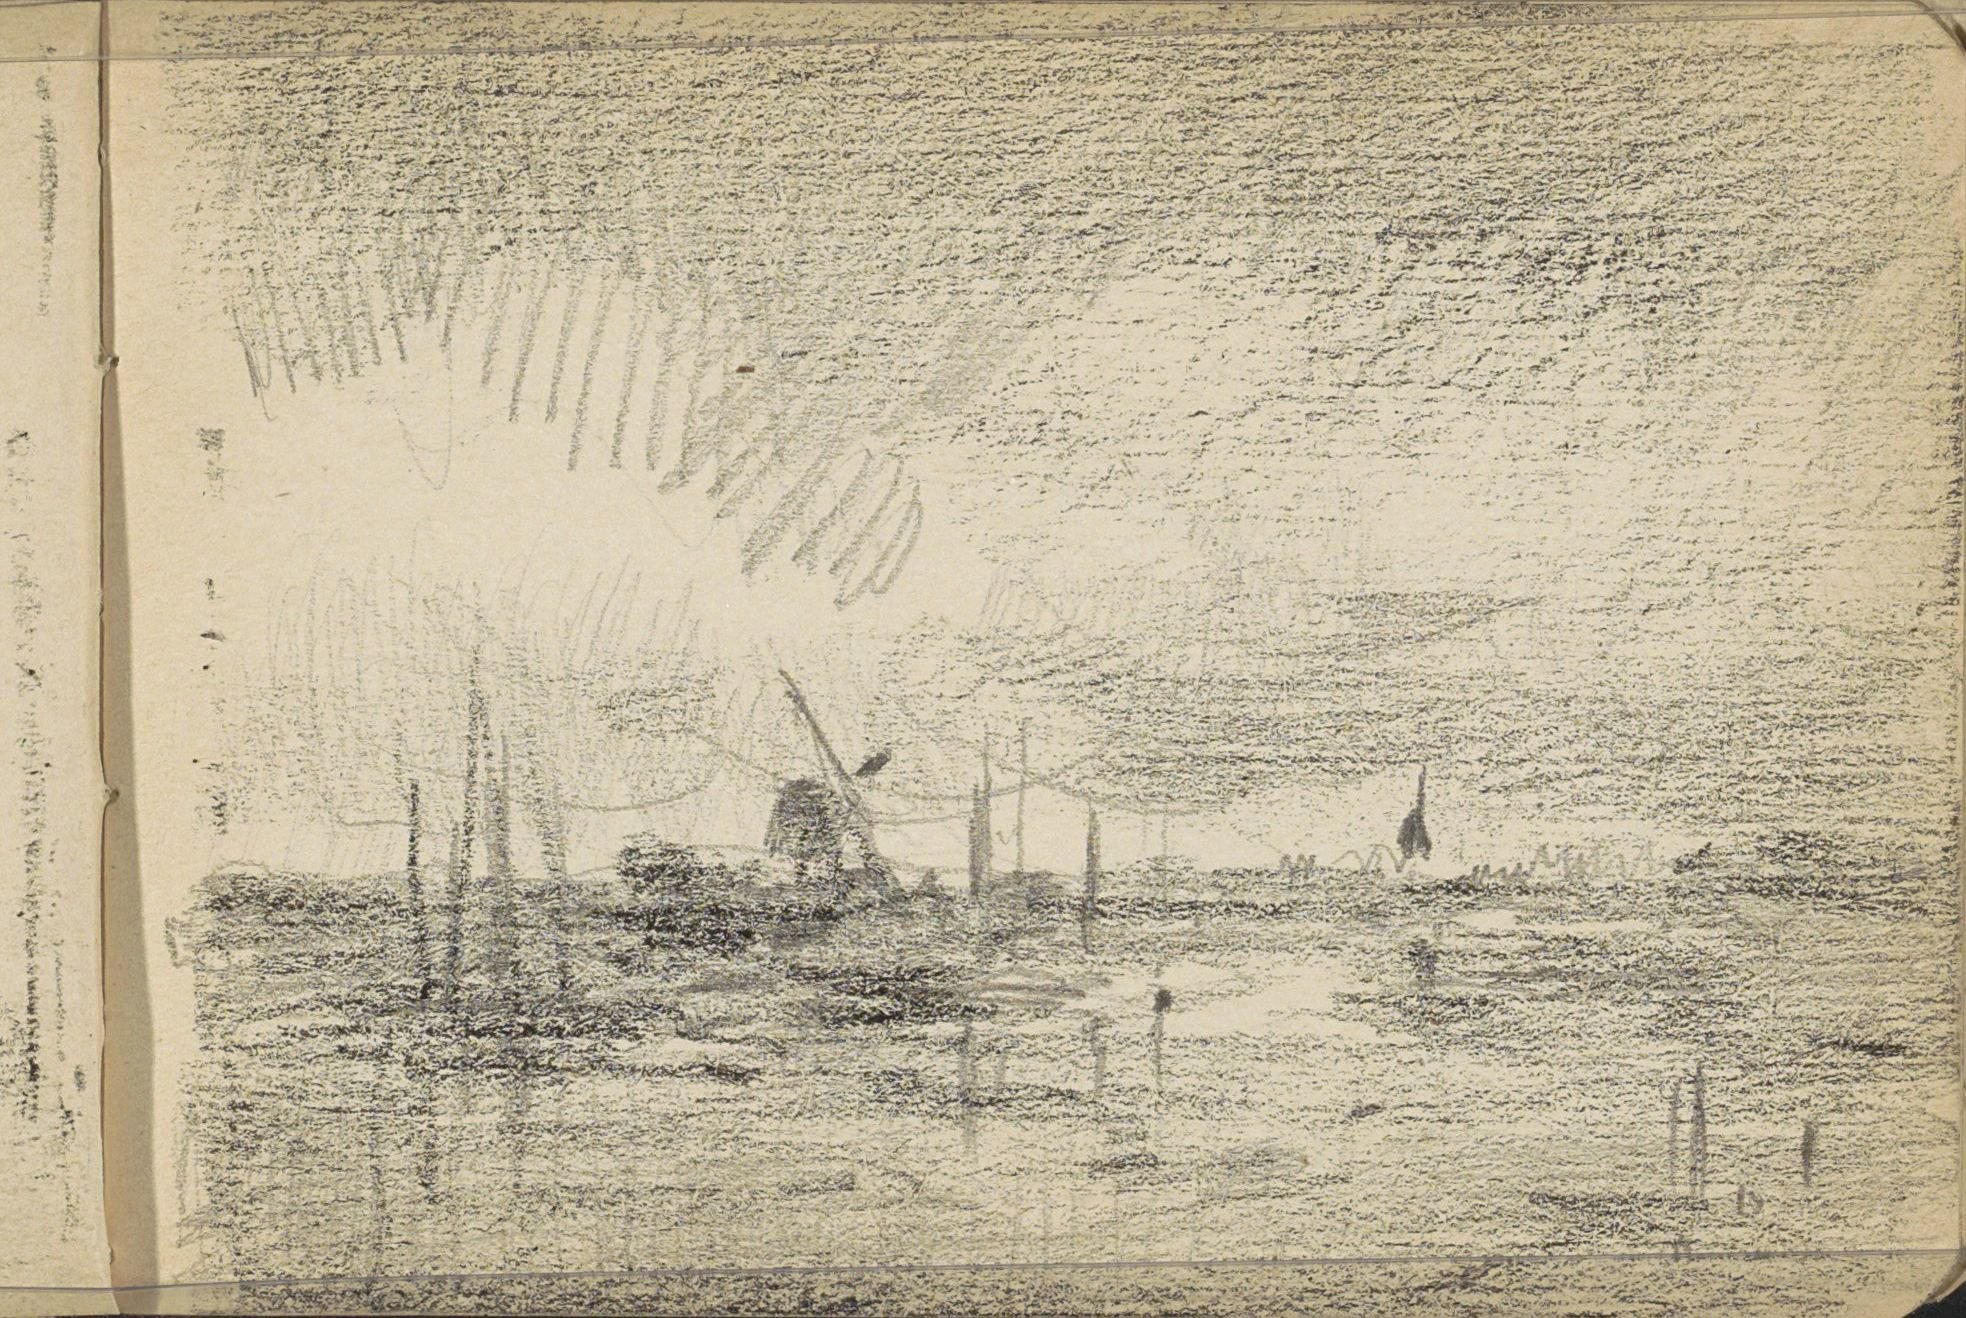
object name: sketchbook leaf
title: Rivierlandschap met een molen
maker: willem cornelis rip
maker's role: draughtsman, painter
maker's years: 1856-1922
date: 1919-1921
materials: chalk, paper, pencil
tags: landscapes with waters, waterscapes, seascapes (in the temperate zone), windmill in landscape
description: Blad 13 recto uit een schetsboek met 42 bladen.